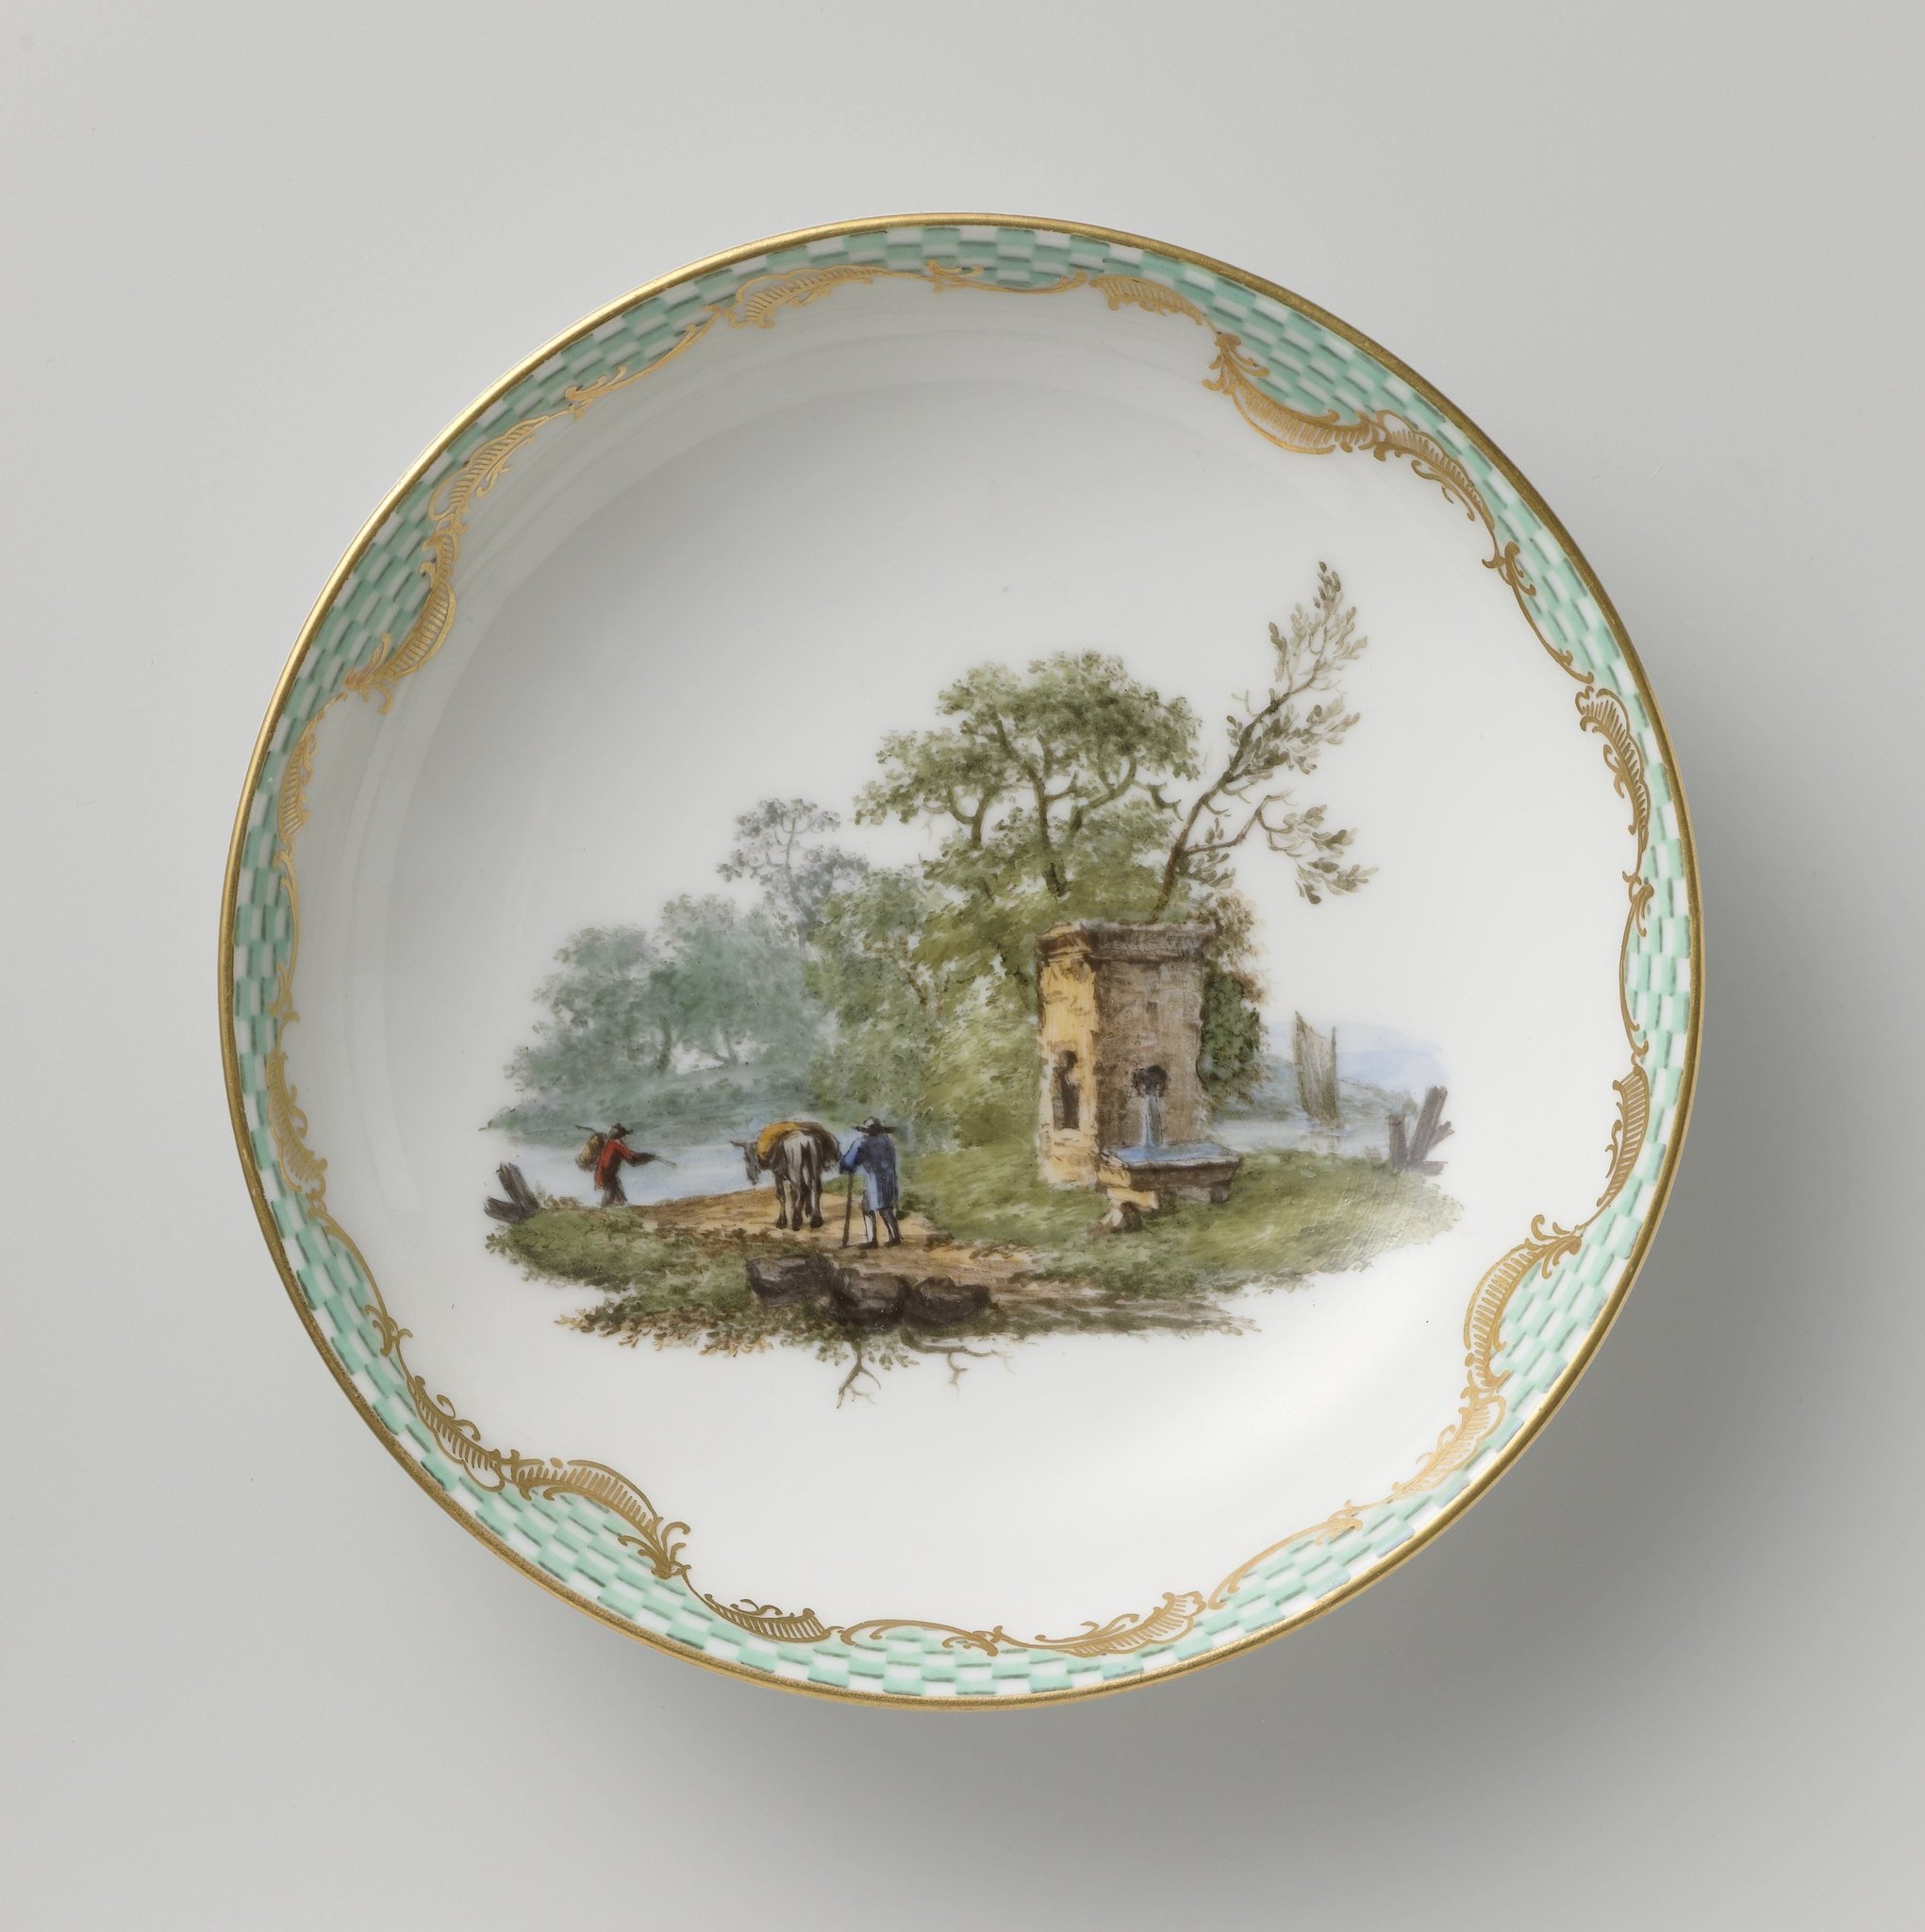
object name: platter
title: Schotel, veelkleurig beschilderd met een landschap met figuren.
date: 1777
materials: porcelain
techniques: painted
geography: meissen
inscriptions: factory mark, mold mark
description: Ronde schotel van beschilderd porselein. De schotel is beschilderd met landschappen waarin figuren en langs de rand een brede strook groen vlechtwerk. De schotel is gemerkt.